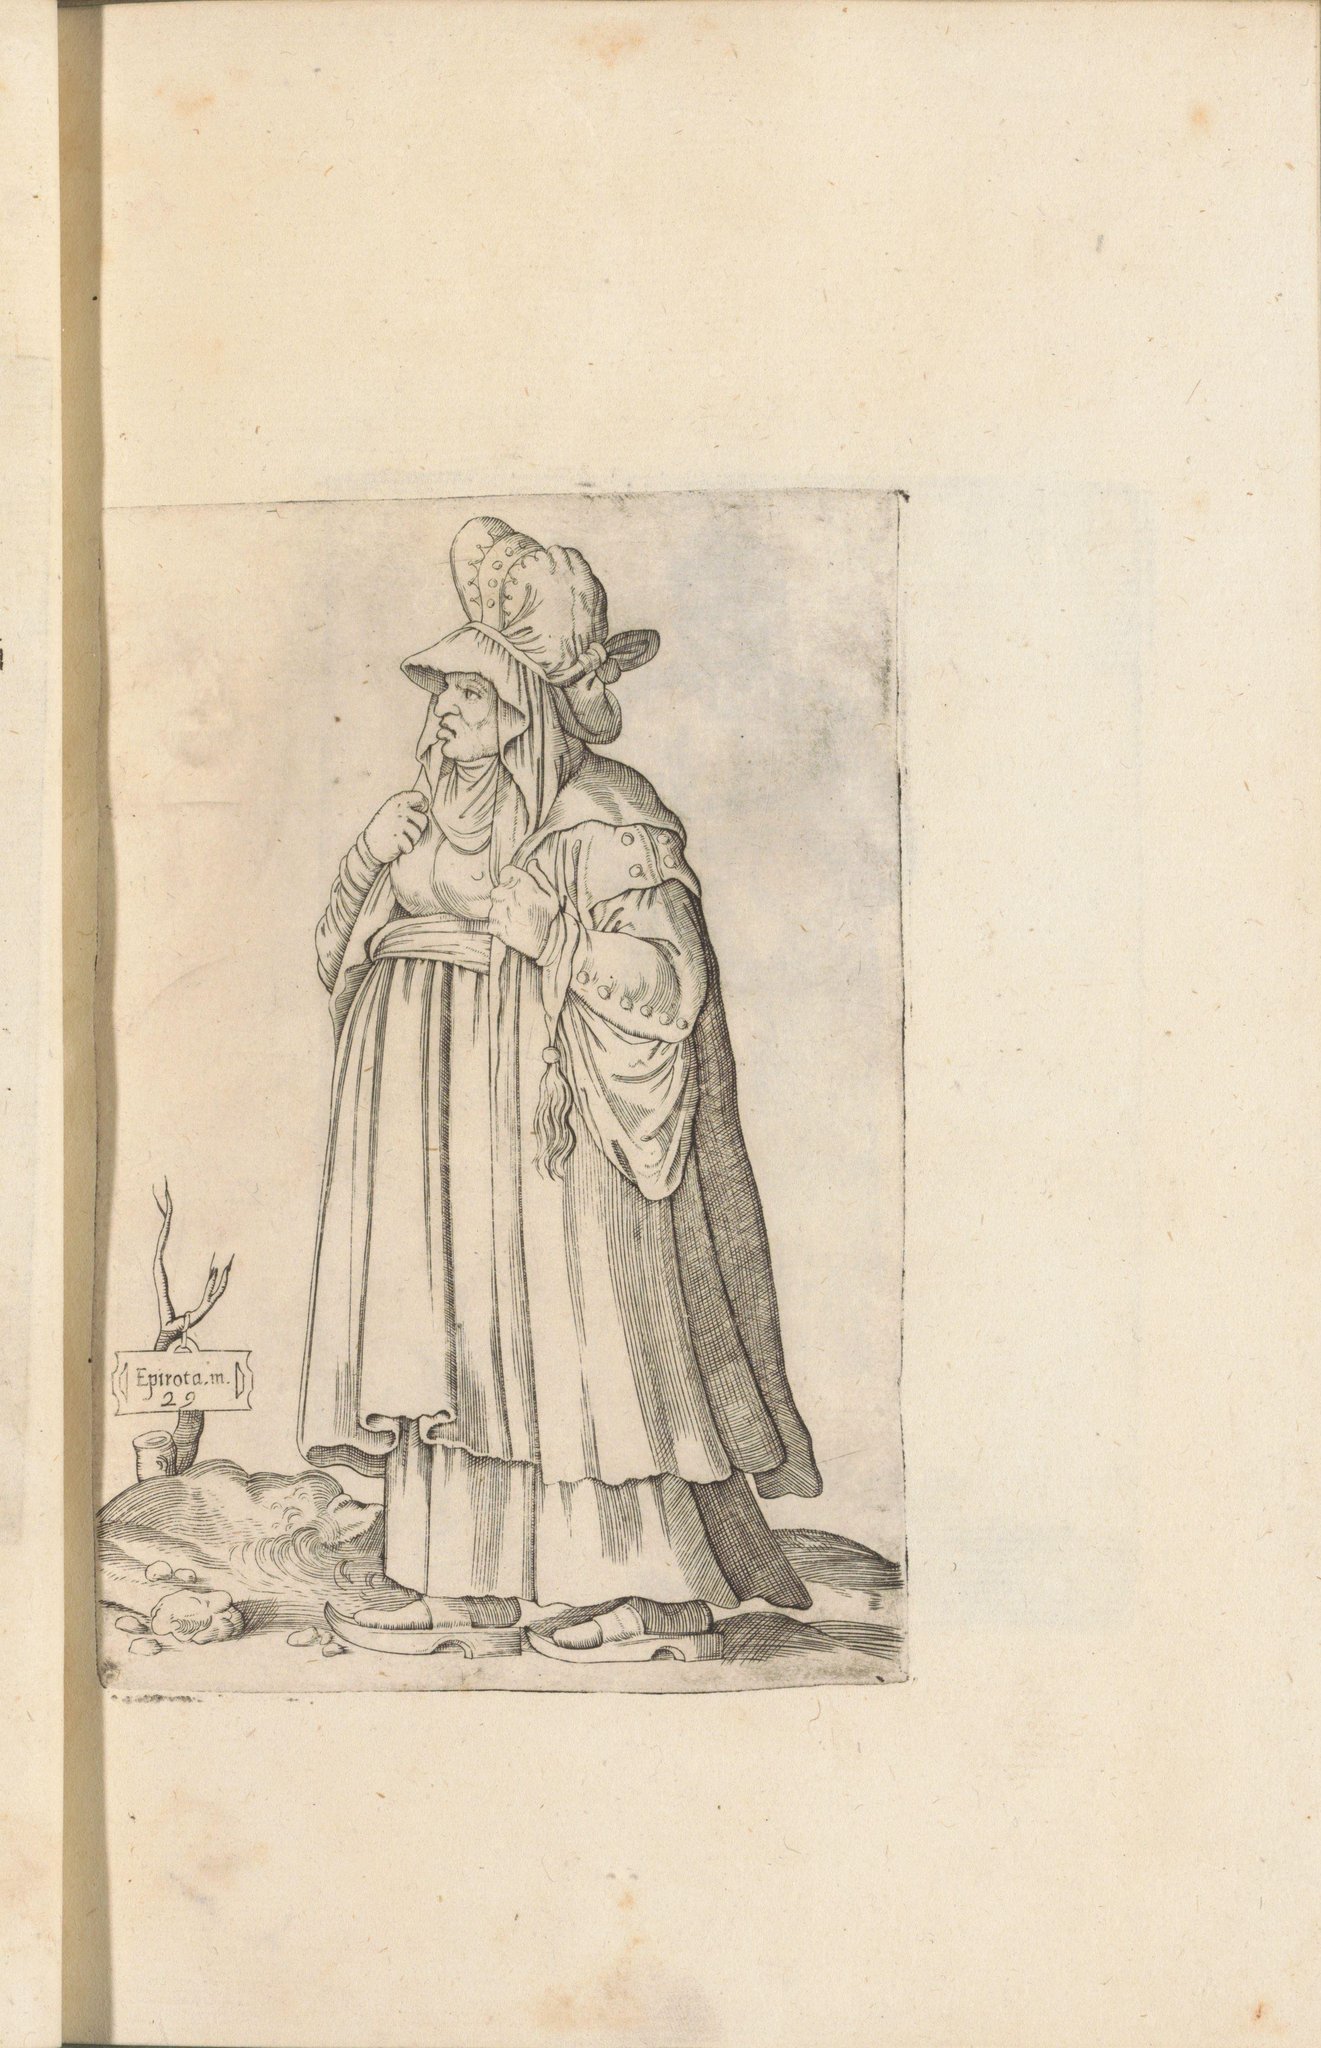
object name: costume print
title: Vrouw uit de Pyreneeën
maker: ferando bertelli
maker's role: print maker, publisher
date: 1569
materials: paper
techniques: engraving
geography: venice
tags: fashion plates, europeans: spaniards (+ women), old woman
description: Oude vrouw uit de Pyreneeën, hoge muts op het hoofd, naar links. Onderdeel van het kostuumboek getiteld 'Omnium fere gentium nostrae aetatis habitus, nunquam ante hac aediti', Venetië 1569. Heruitgave uit 1569 van de eerste editie uit 1563.